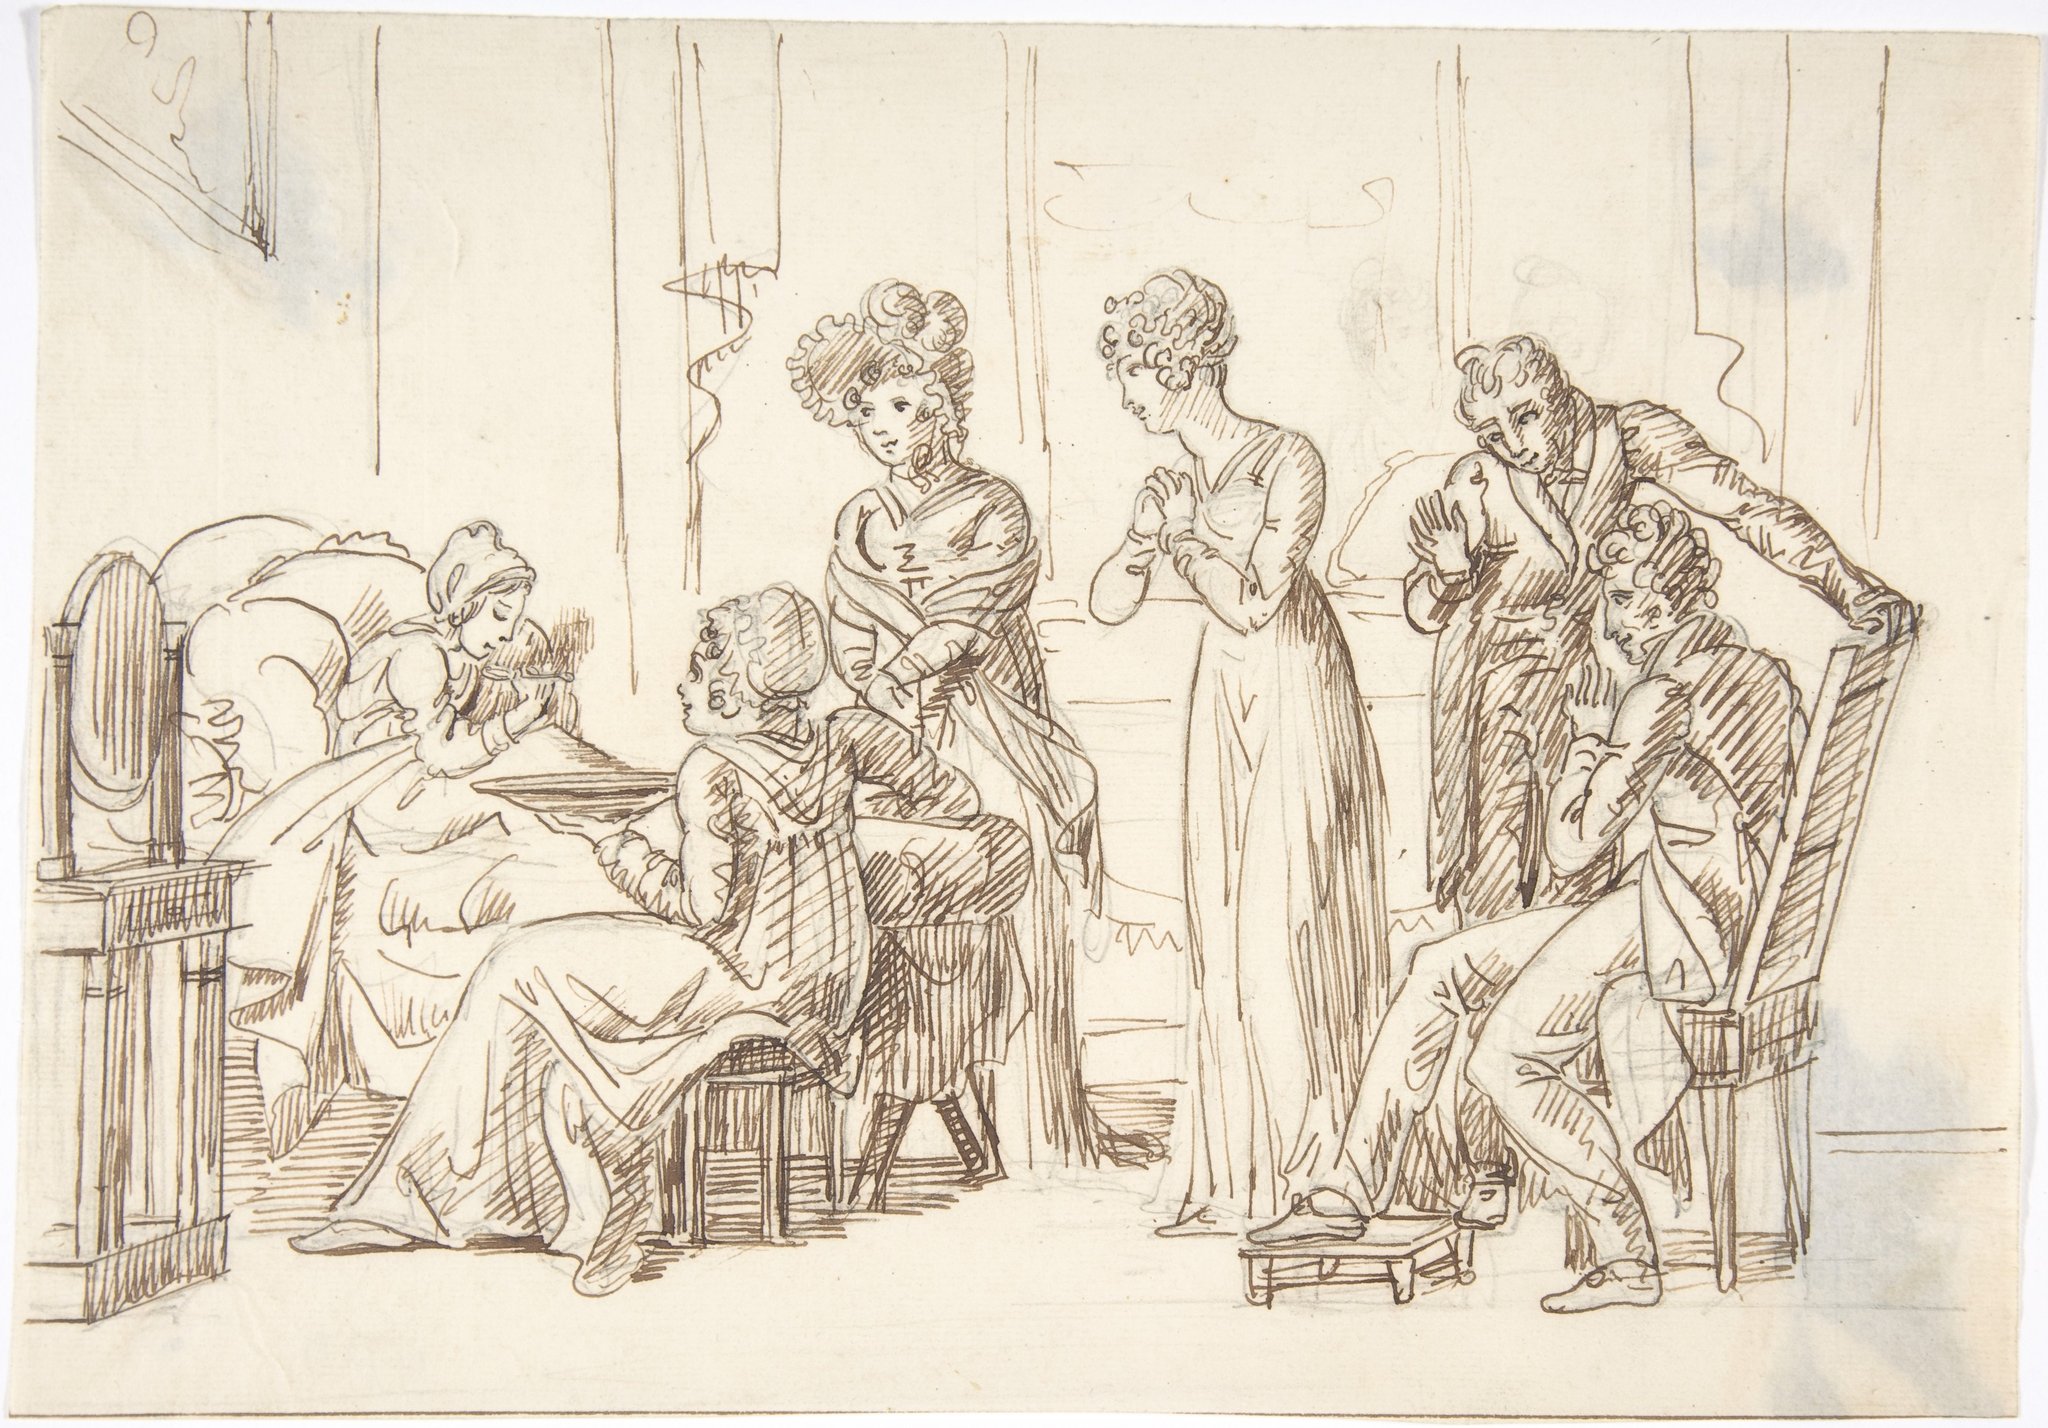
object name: drawing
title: A Bedroom Scene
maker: anonymous, french, 19th century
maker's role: artist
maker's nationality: french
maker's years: 1800-1900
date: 1801-1900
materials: graphite, ink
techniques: pen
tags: bedrooms,men,women